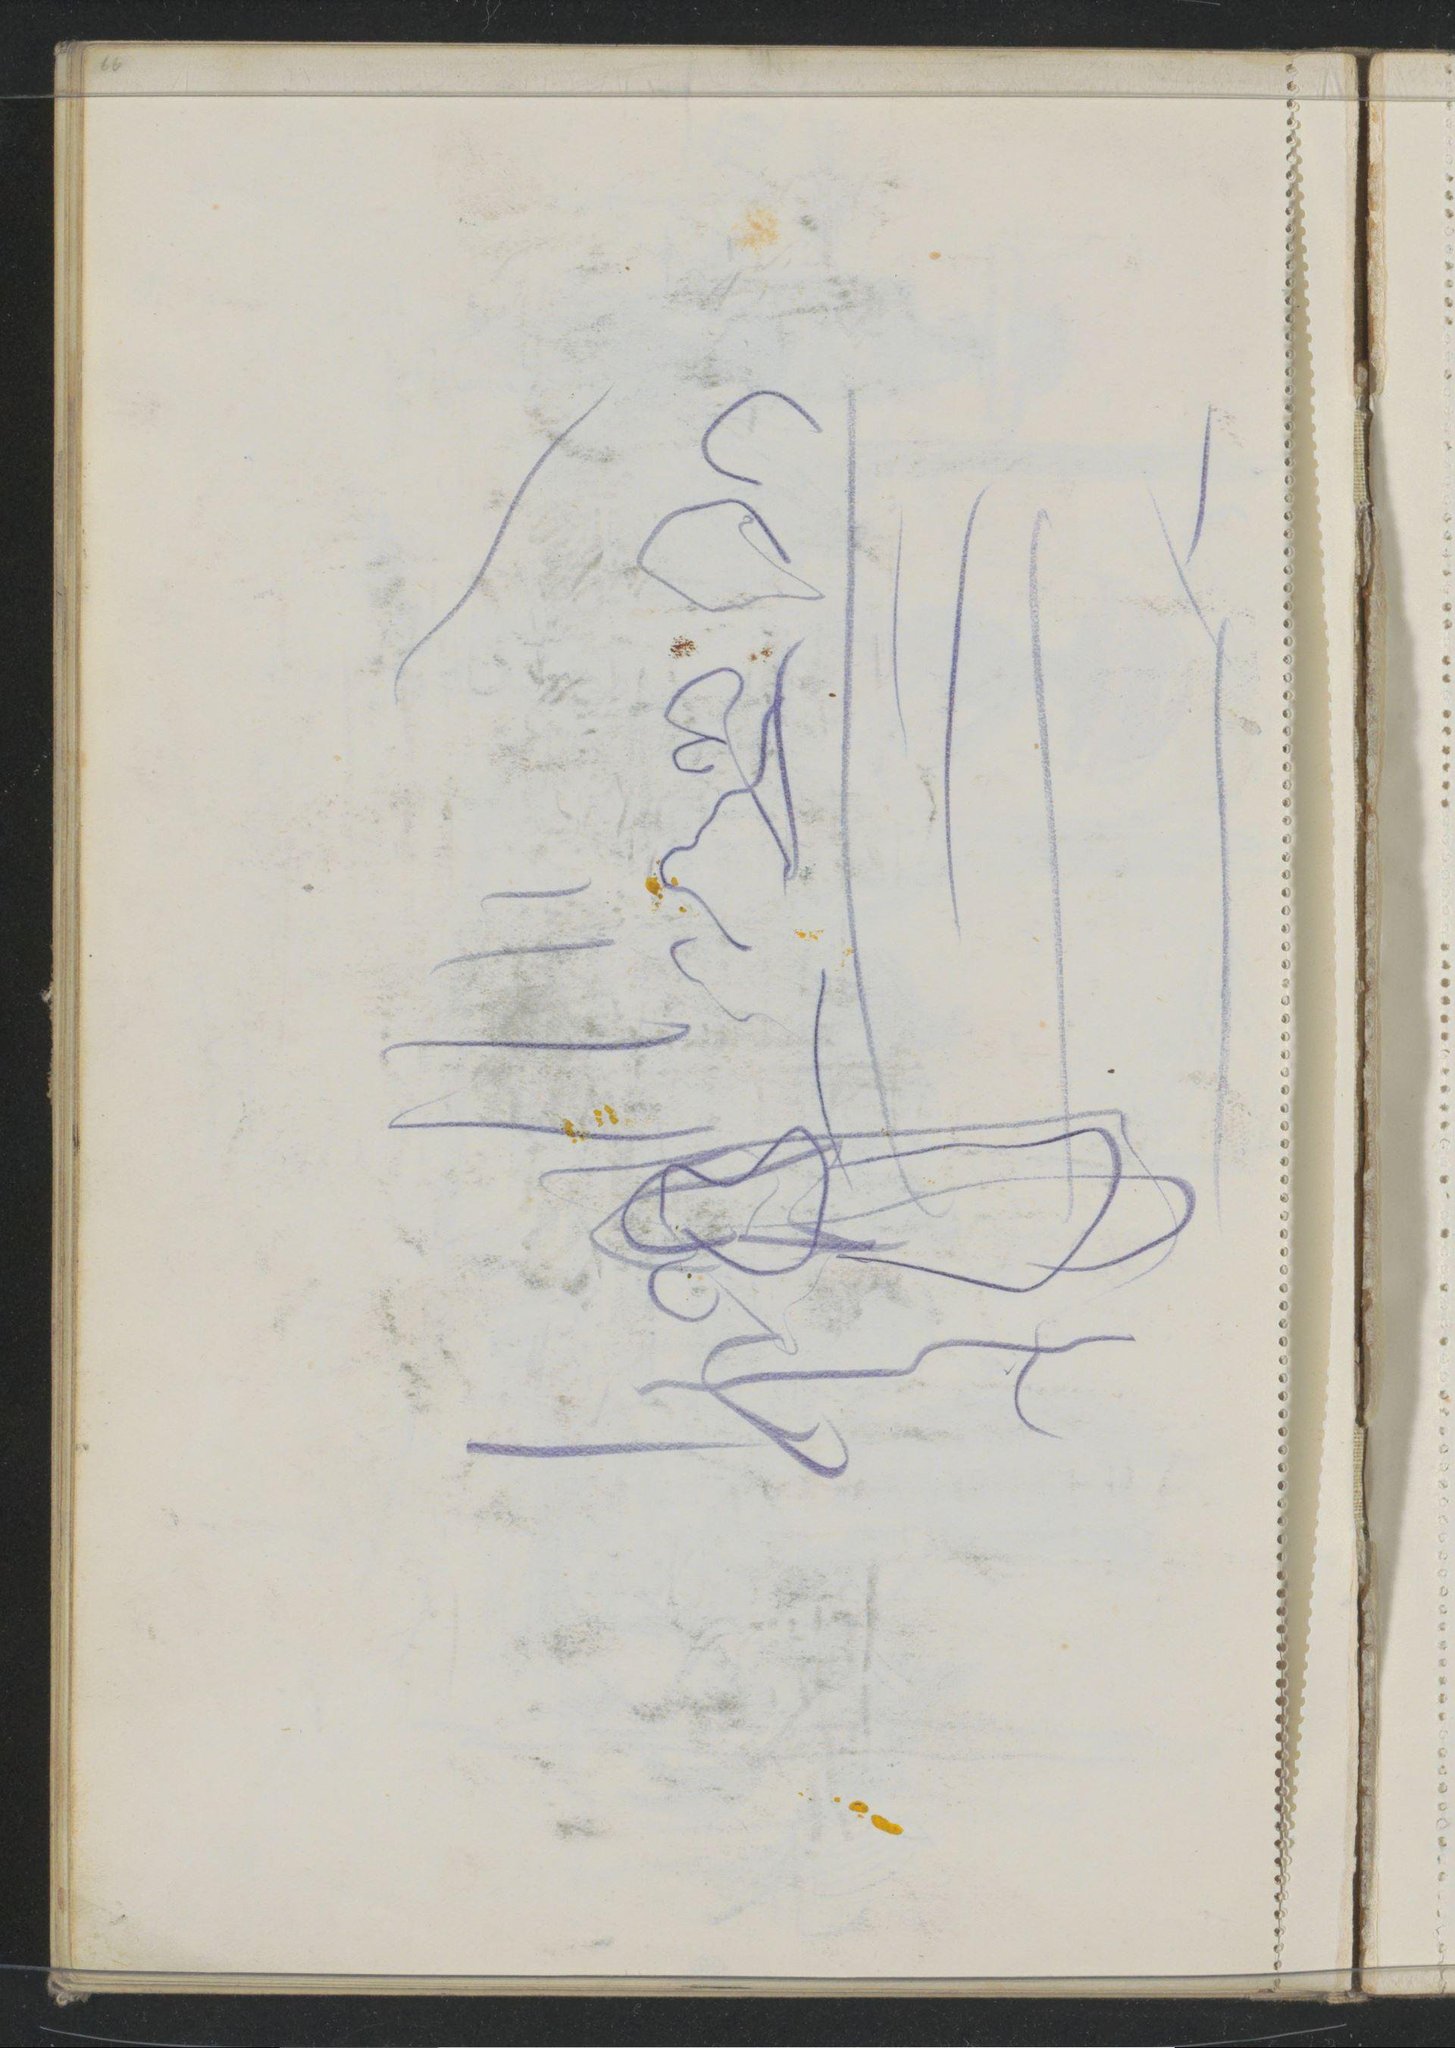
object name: sketchbook leaf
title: Figuurstudies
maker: marius bauer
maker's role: draughtsman, print maker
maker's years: 1867-1932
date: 1925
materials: paper, pencil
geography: indonesia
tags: anatomy (non-medical)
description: Pagina 66 uit een schetsboek met 74 bladen.